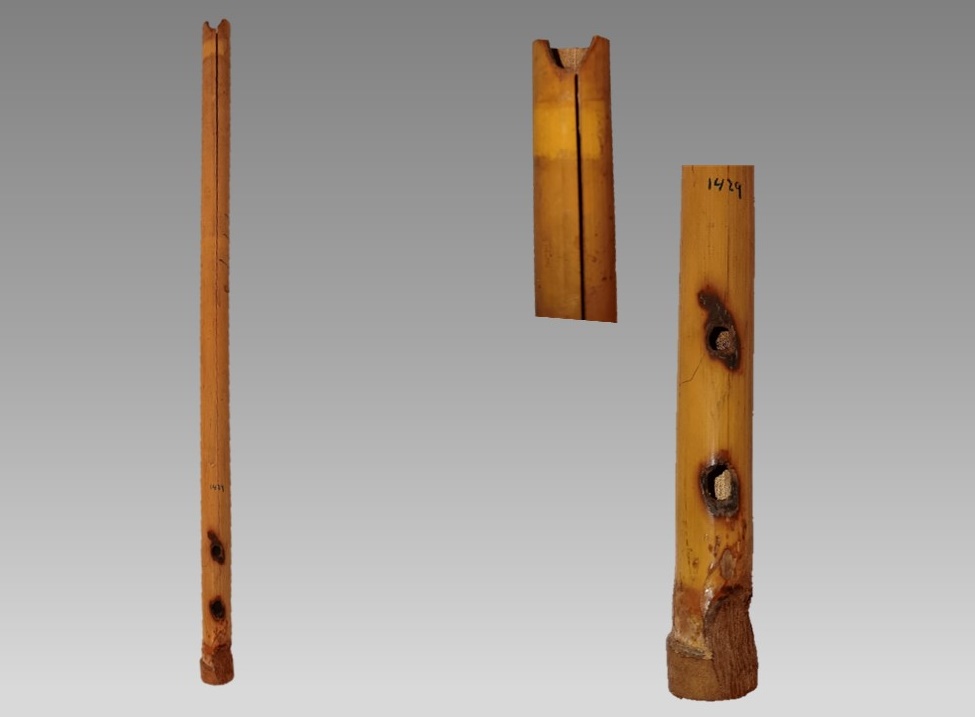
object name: gore notched flute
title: Gore (notched flute)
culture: polynesian or norfolk island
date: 1867-1900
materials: bamboo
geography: australia